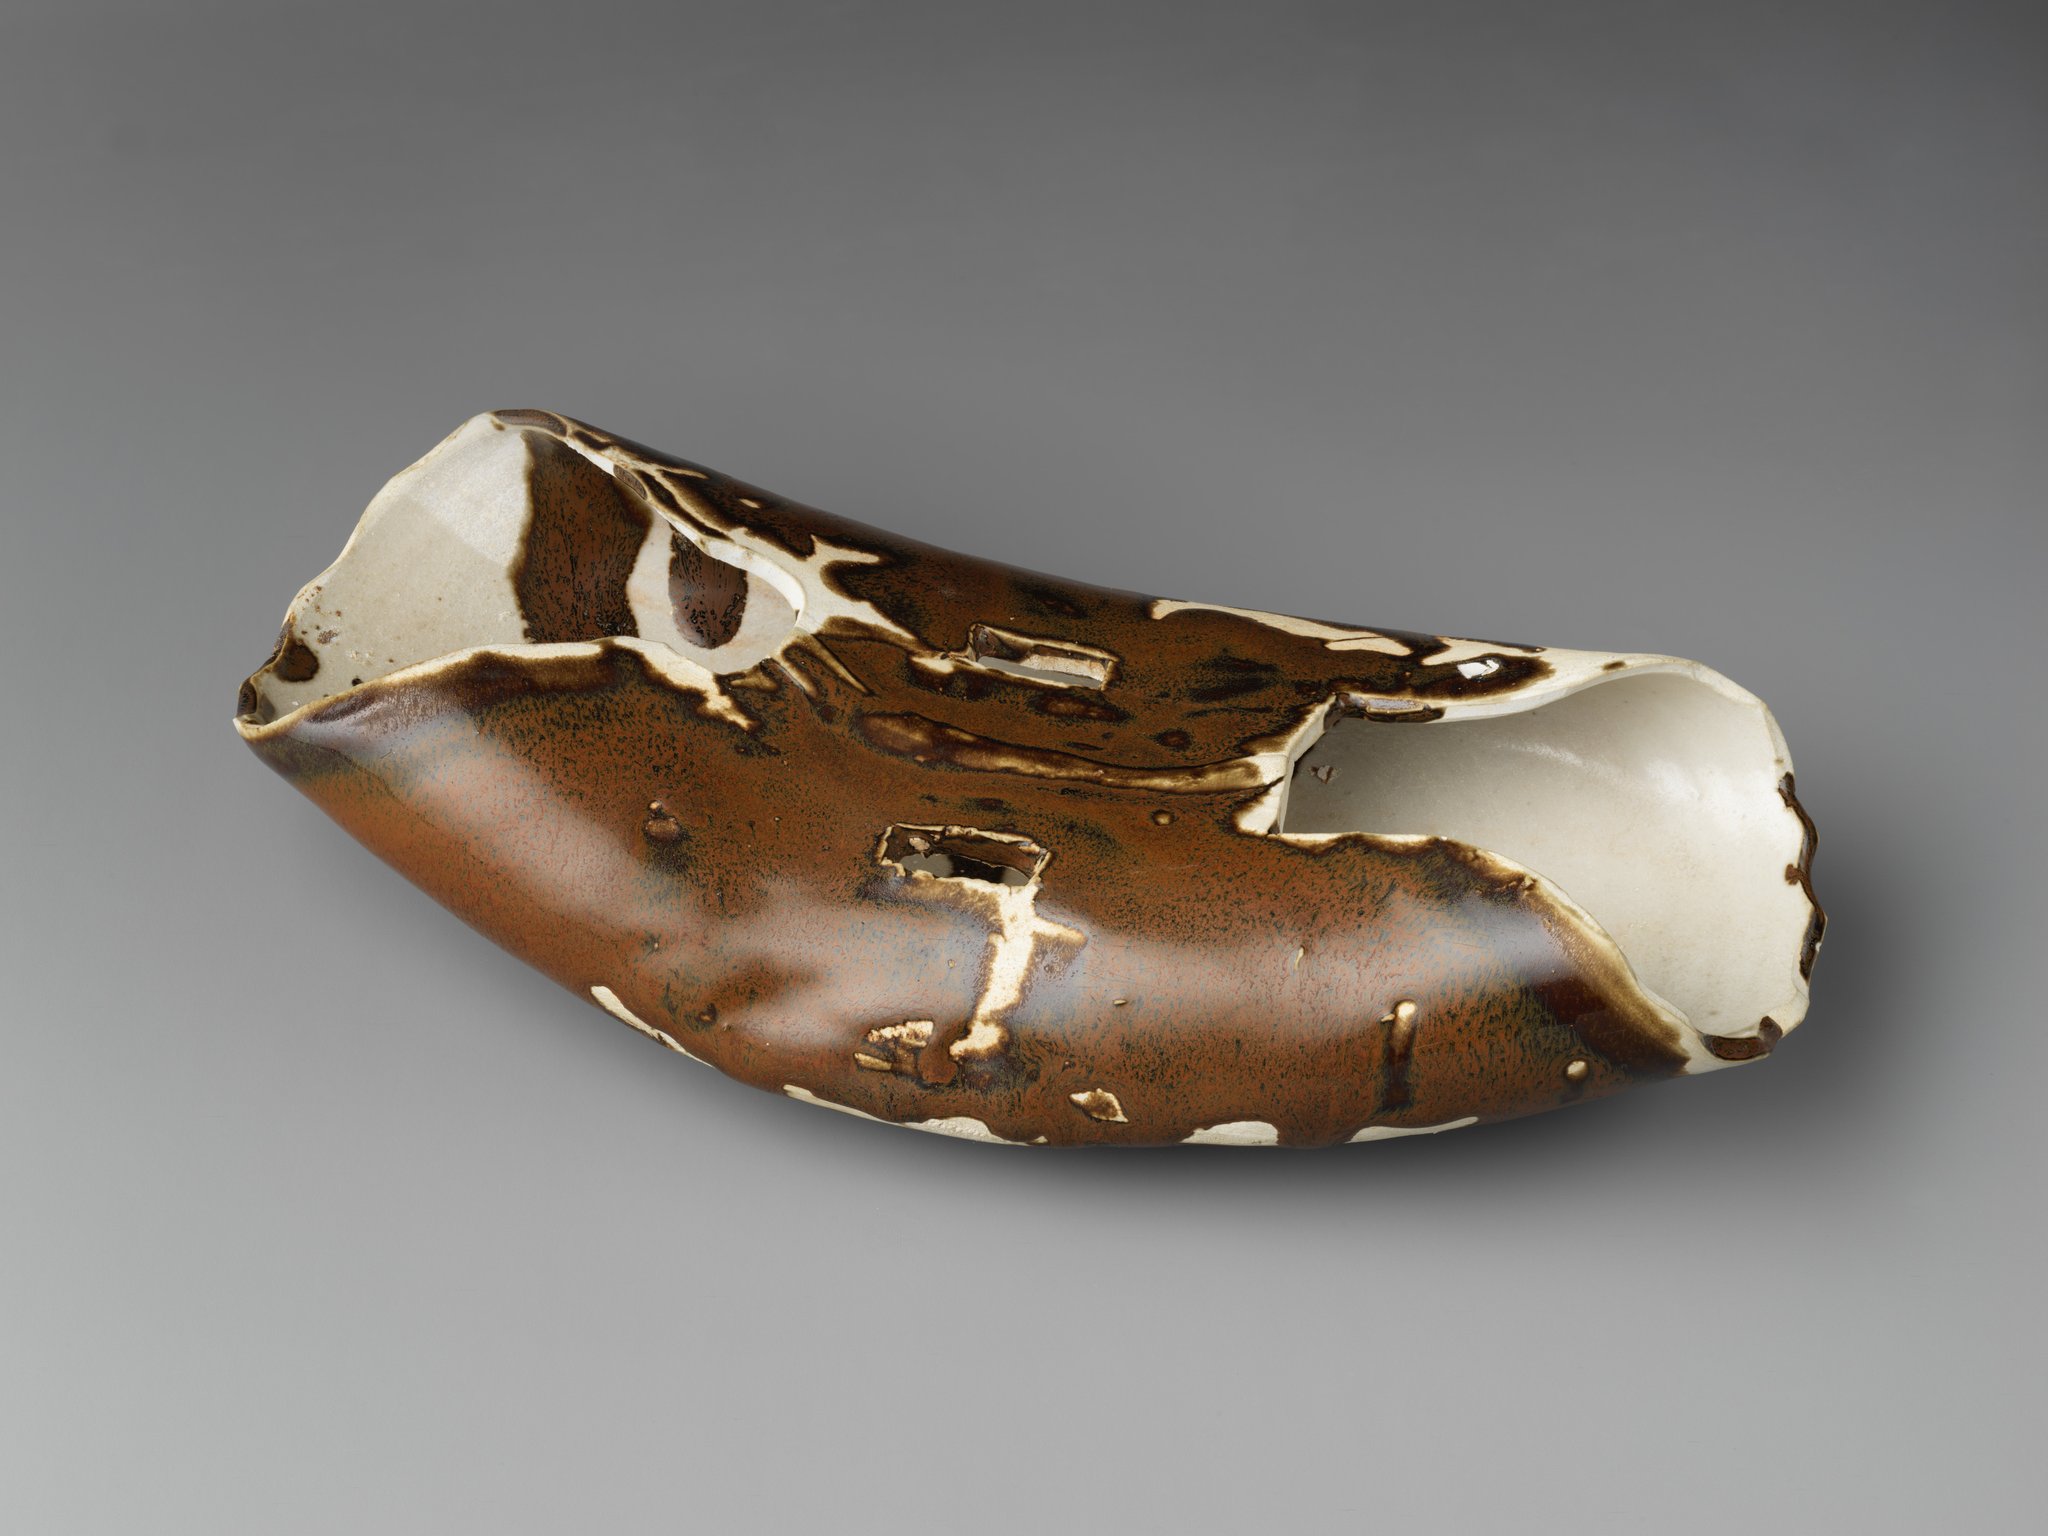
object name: vessel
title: Vessel in the shape of a leather wrapper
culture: chinese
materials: glaze, porcelain